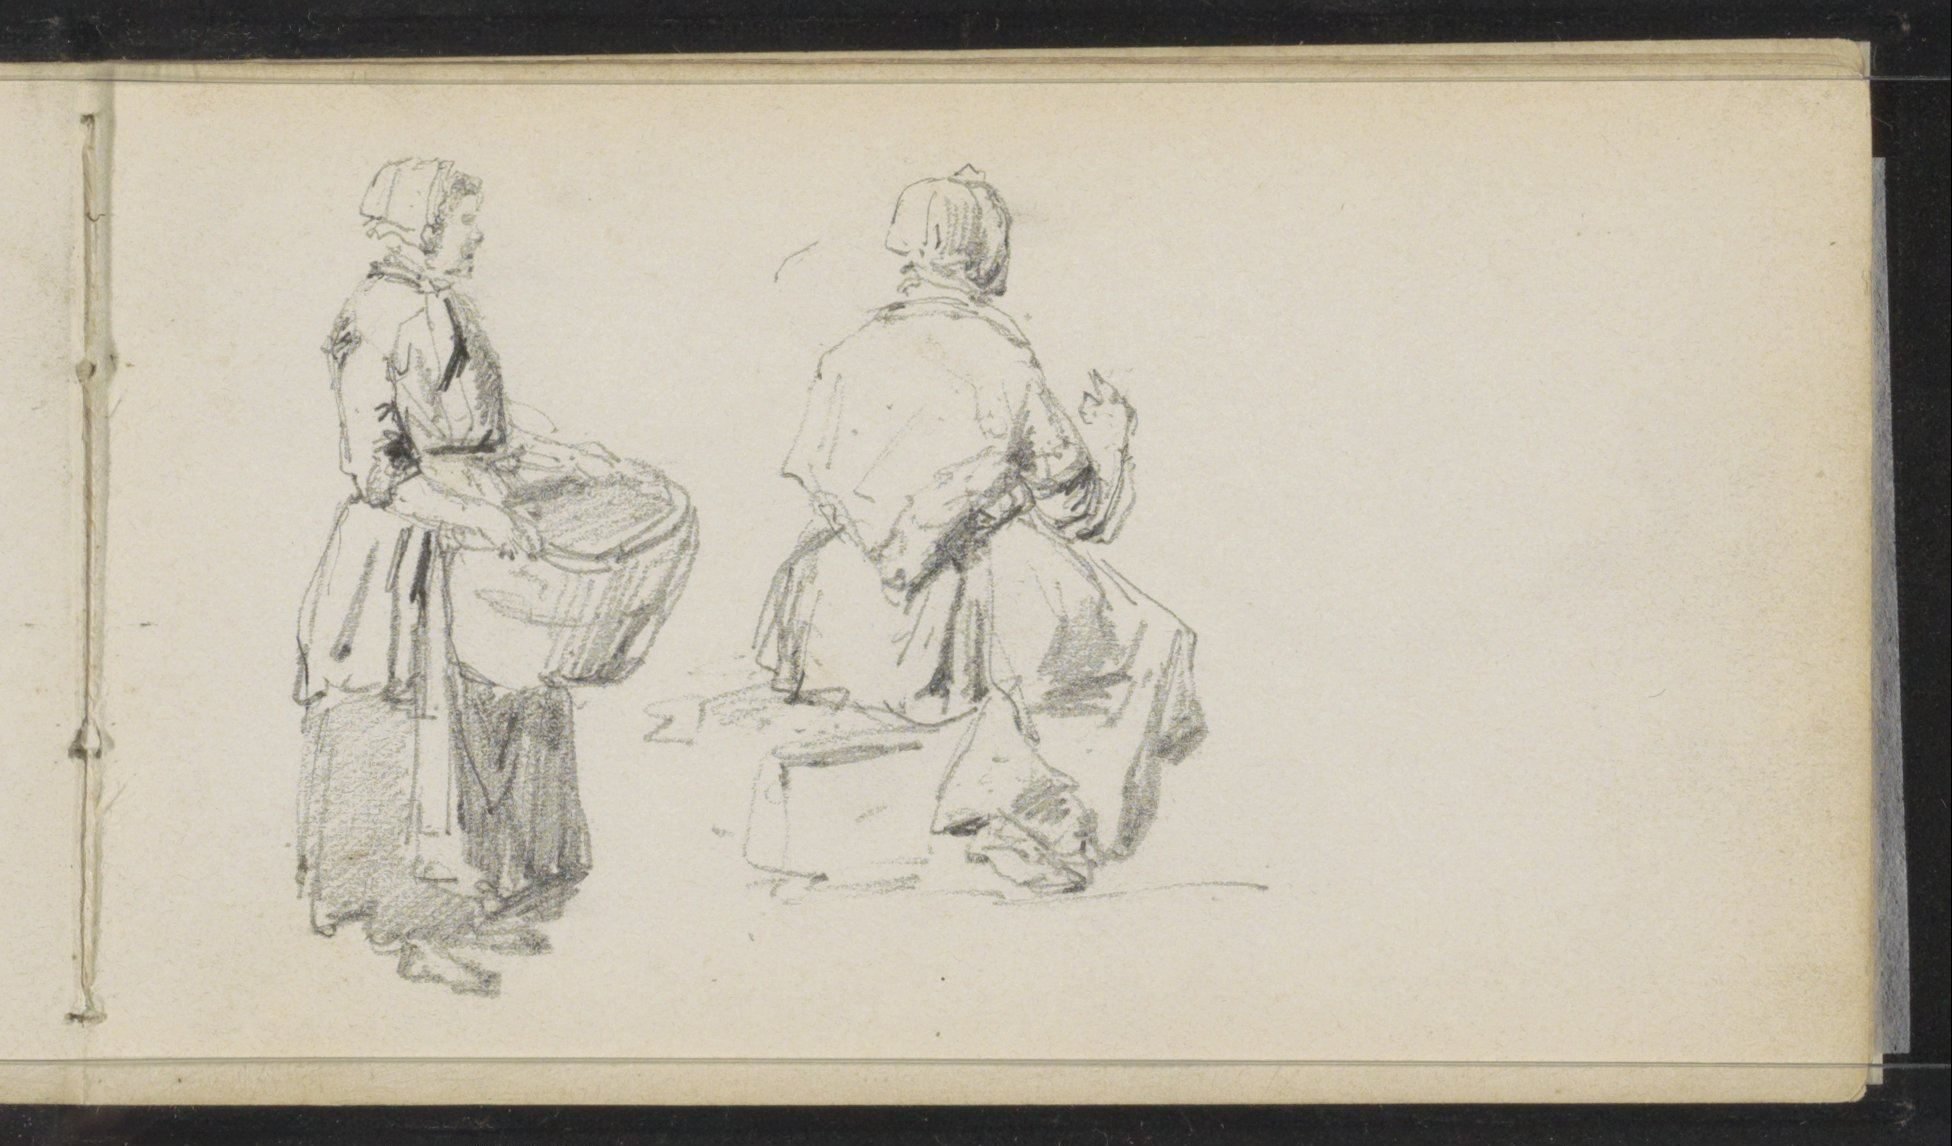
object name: sketchbook leaf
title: Staande en zittende vrouw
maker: cornelis springer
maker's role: draughtsman, painter, print maker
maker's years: 1817-1891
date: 1860-1866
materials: paper, pencil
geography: netherlands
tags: sitting figure - aa - female human figure, standing figure - aa - female human figure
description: Links een vrouw met mand in haar handen. Rechts een zittende vrouw. Blad 4 uit een schetsboek met 44 bladen.